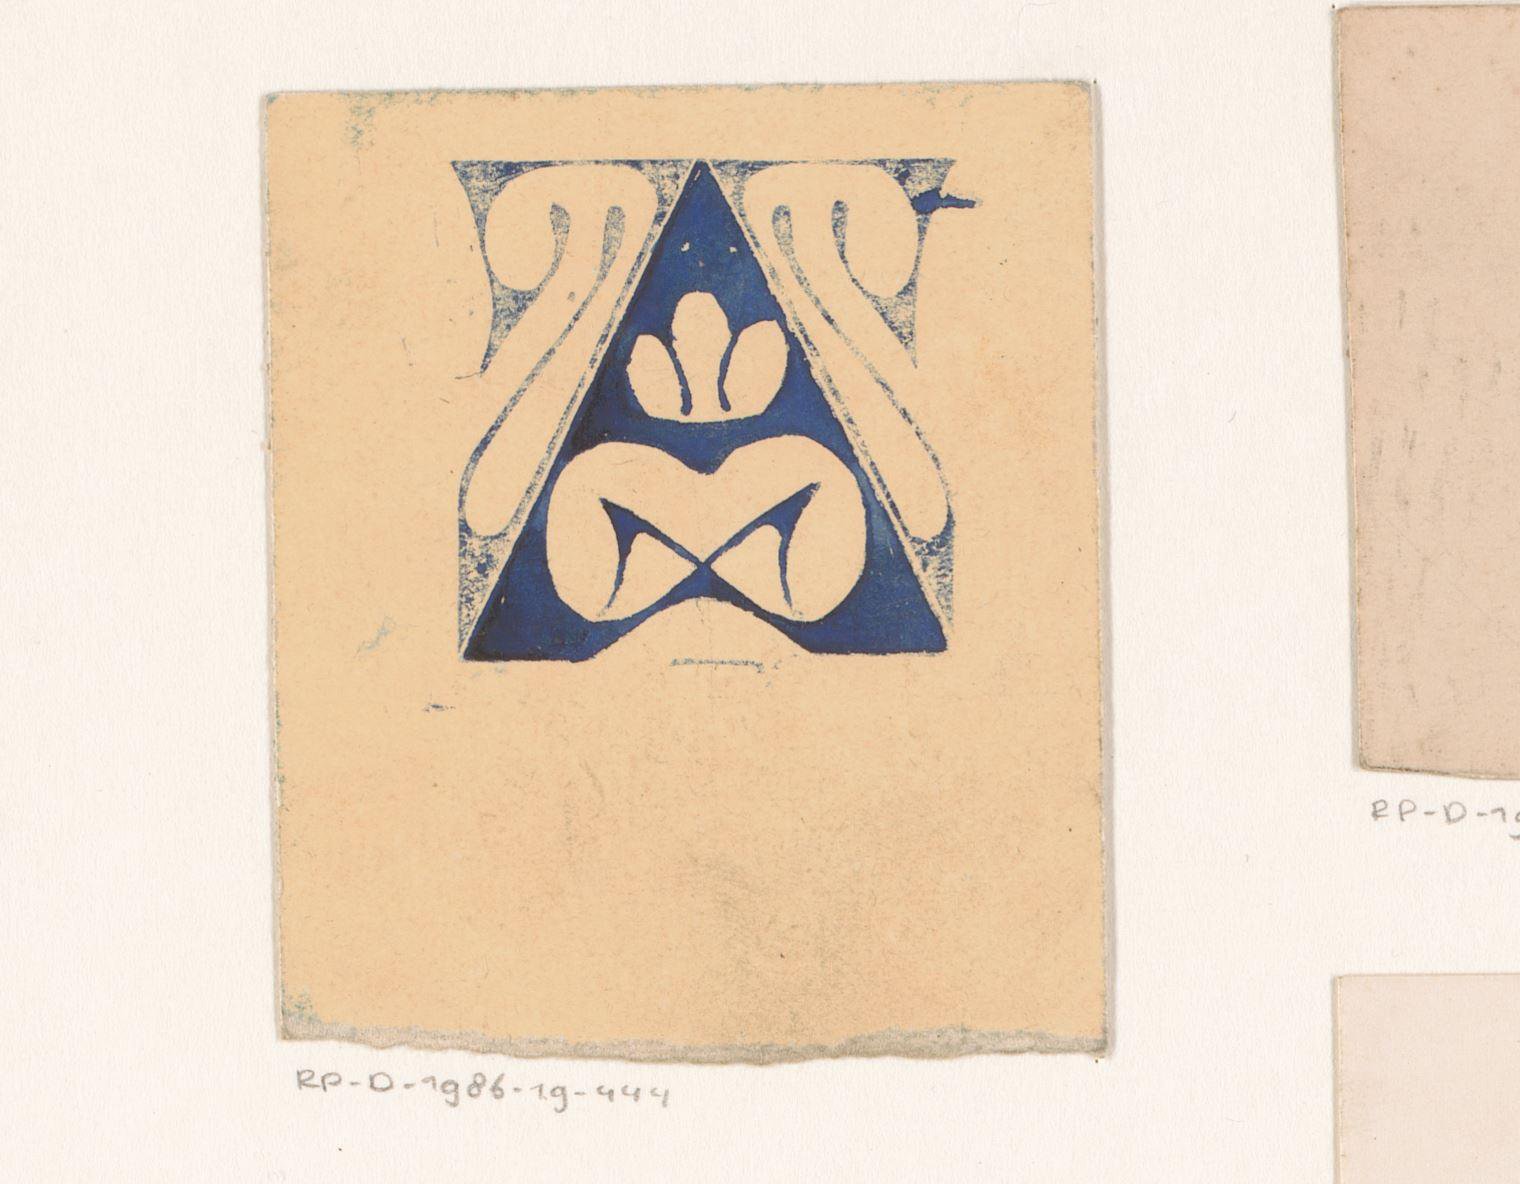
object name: drawing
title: Ornament met driehoek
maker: reinier willem petrus de vries (1874-1953)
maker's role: draughtsman, print maker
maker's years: 1874-1953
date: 1884-1952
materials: ink, paper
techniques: brush, printing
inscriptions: collector's mark: ‘R:MVS.’